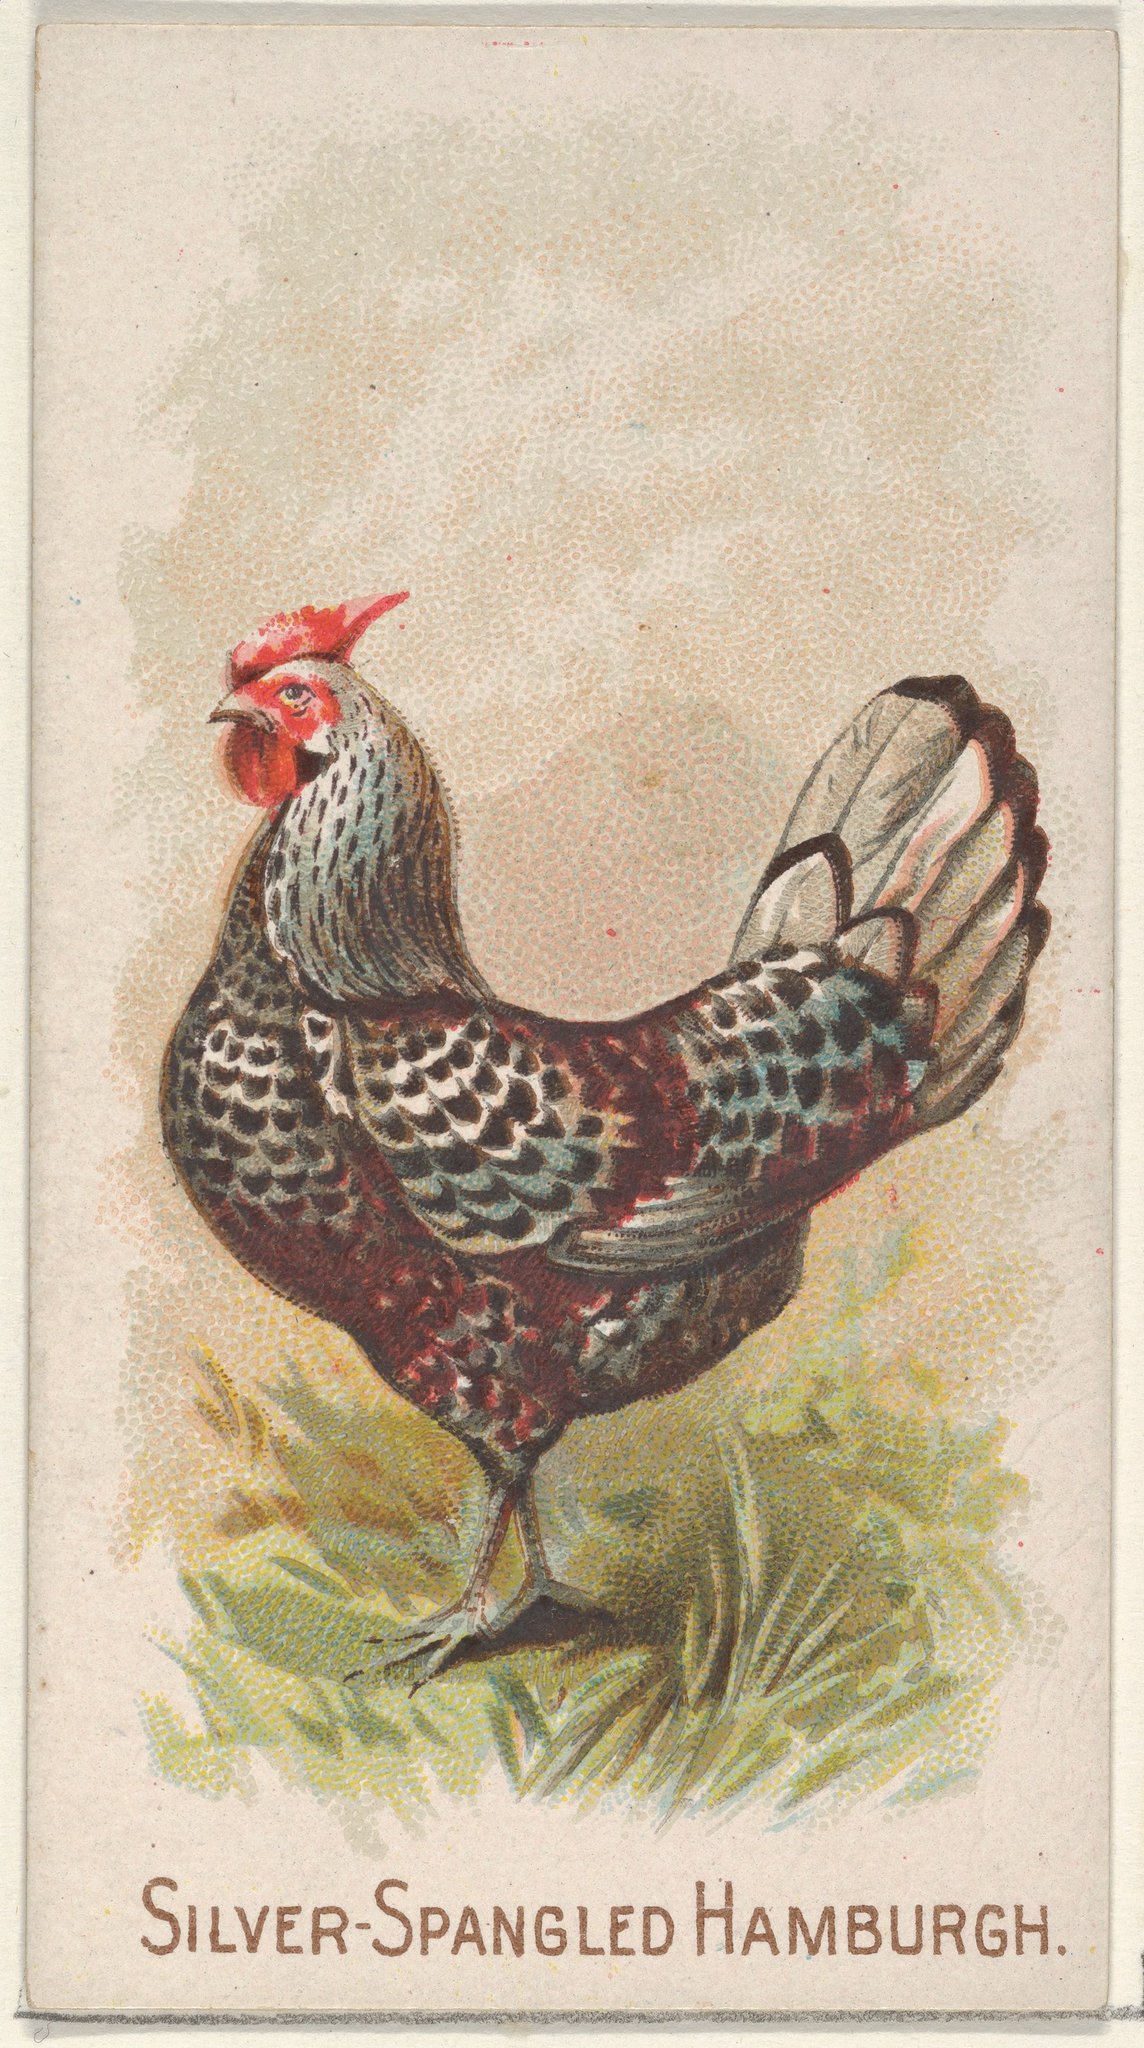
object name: print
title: Silver-Spangled Hamburgh, from the Prize and Game Chickens series (N20) for Allen & Ginter Cigarettes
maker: allen & ginter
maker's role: publisher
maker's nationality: american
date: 1891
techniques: color lithograph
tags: chickens